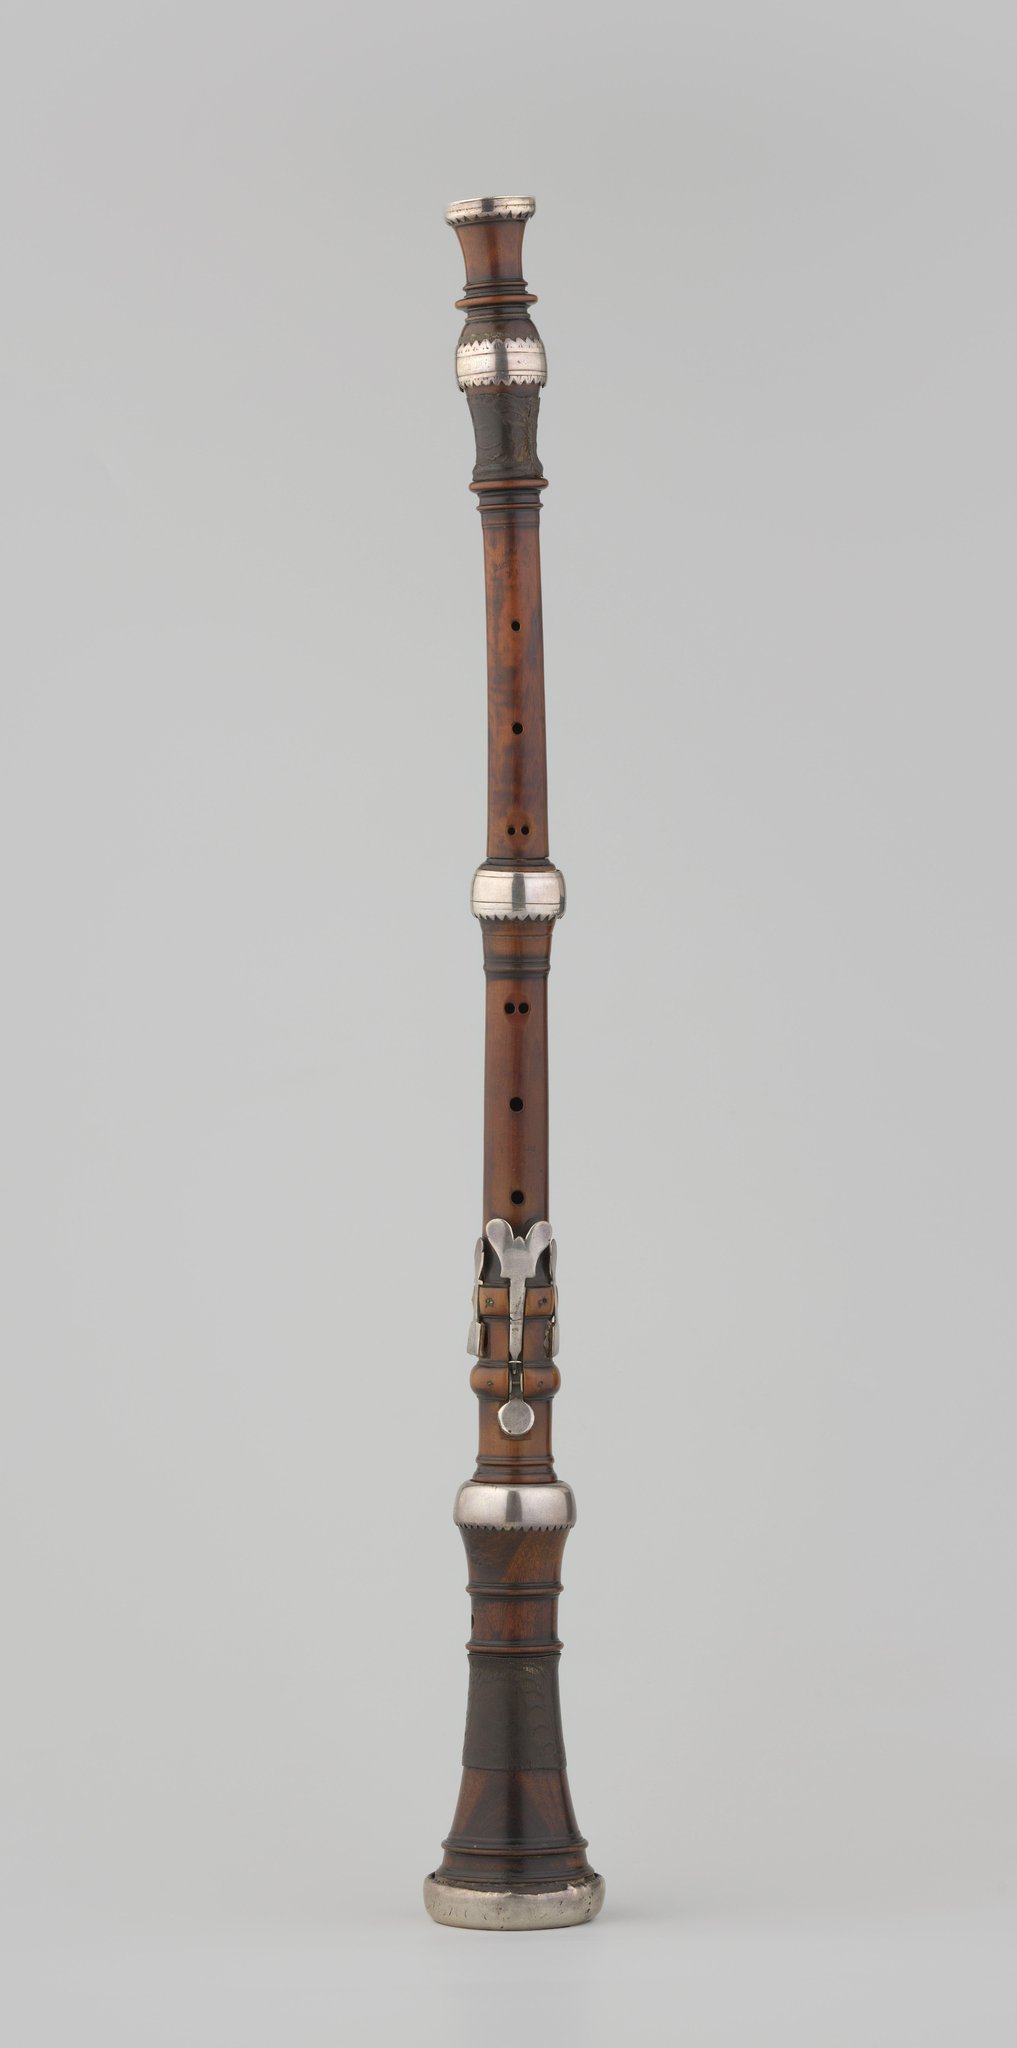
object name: oboe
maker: philip borkens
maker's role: musical instrument maker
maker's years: 1693-1765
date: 1750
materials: wood, silver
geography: amsterdam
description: Music has always been a crucial element of public celebrations, such as military parades, coronations, royal weddings, and funerals, adding grandeur to the solemnity of the occasion. Musical ensembles entrusted with performing music at these events have existed in Europe since the Middle Ages. This display highlights various marching bands and their musical instruments dating from the 16th to the 19th century.